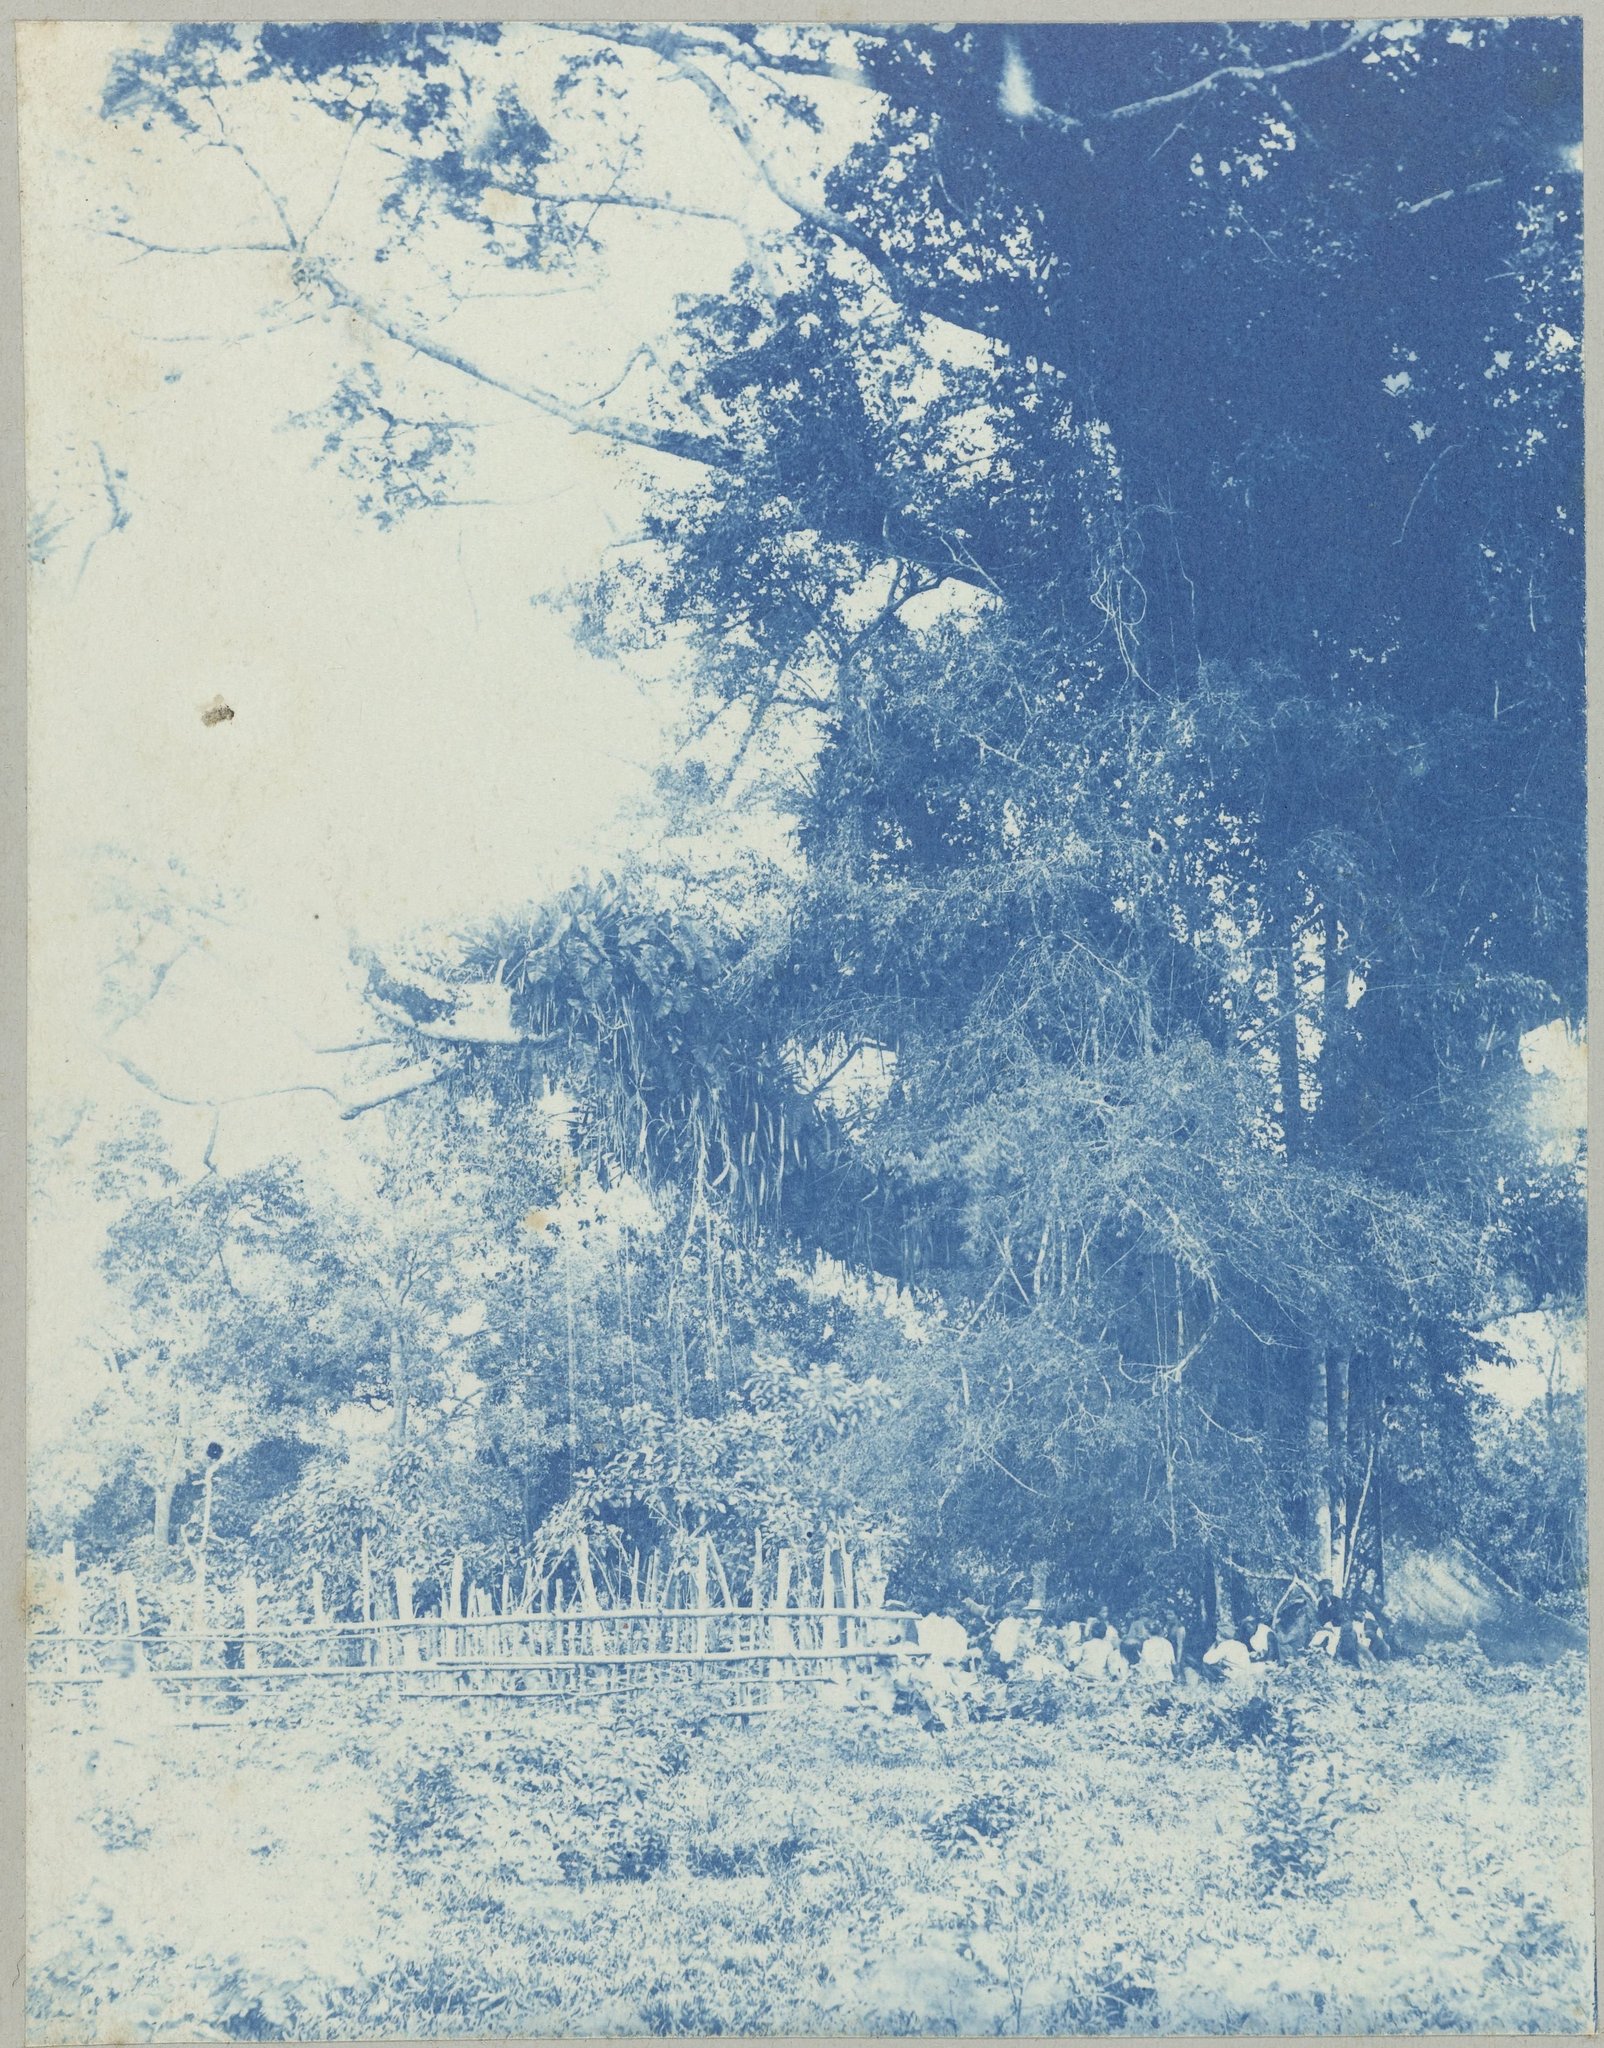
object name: photograph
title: Javanenmarkt op "Ma retraite"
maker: hendrik doijer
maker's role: engineer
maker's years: 1863-1925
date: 1903-1910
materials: photographic support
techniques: cyanotype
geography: suriname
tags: suriname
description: Kleine markt van Javanen in de openlucht onder een grote boom op het terrein van de plantage Ma Retraite. Onderdeel van het fotoalbum Souvenir de Voyage (deel 1), over het leven van de familie Doijer in en rond de plantage Ma Retraite in Suriname in de jaren 1903-1910.